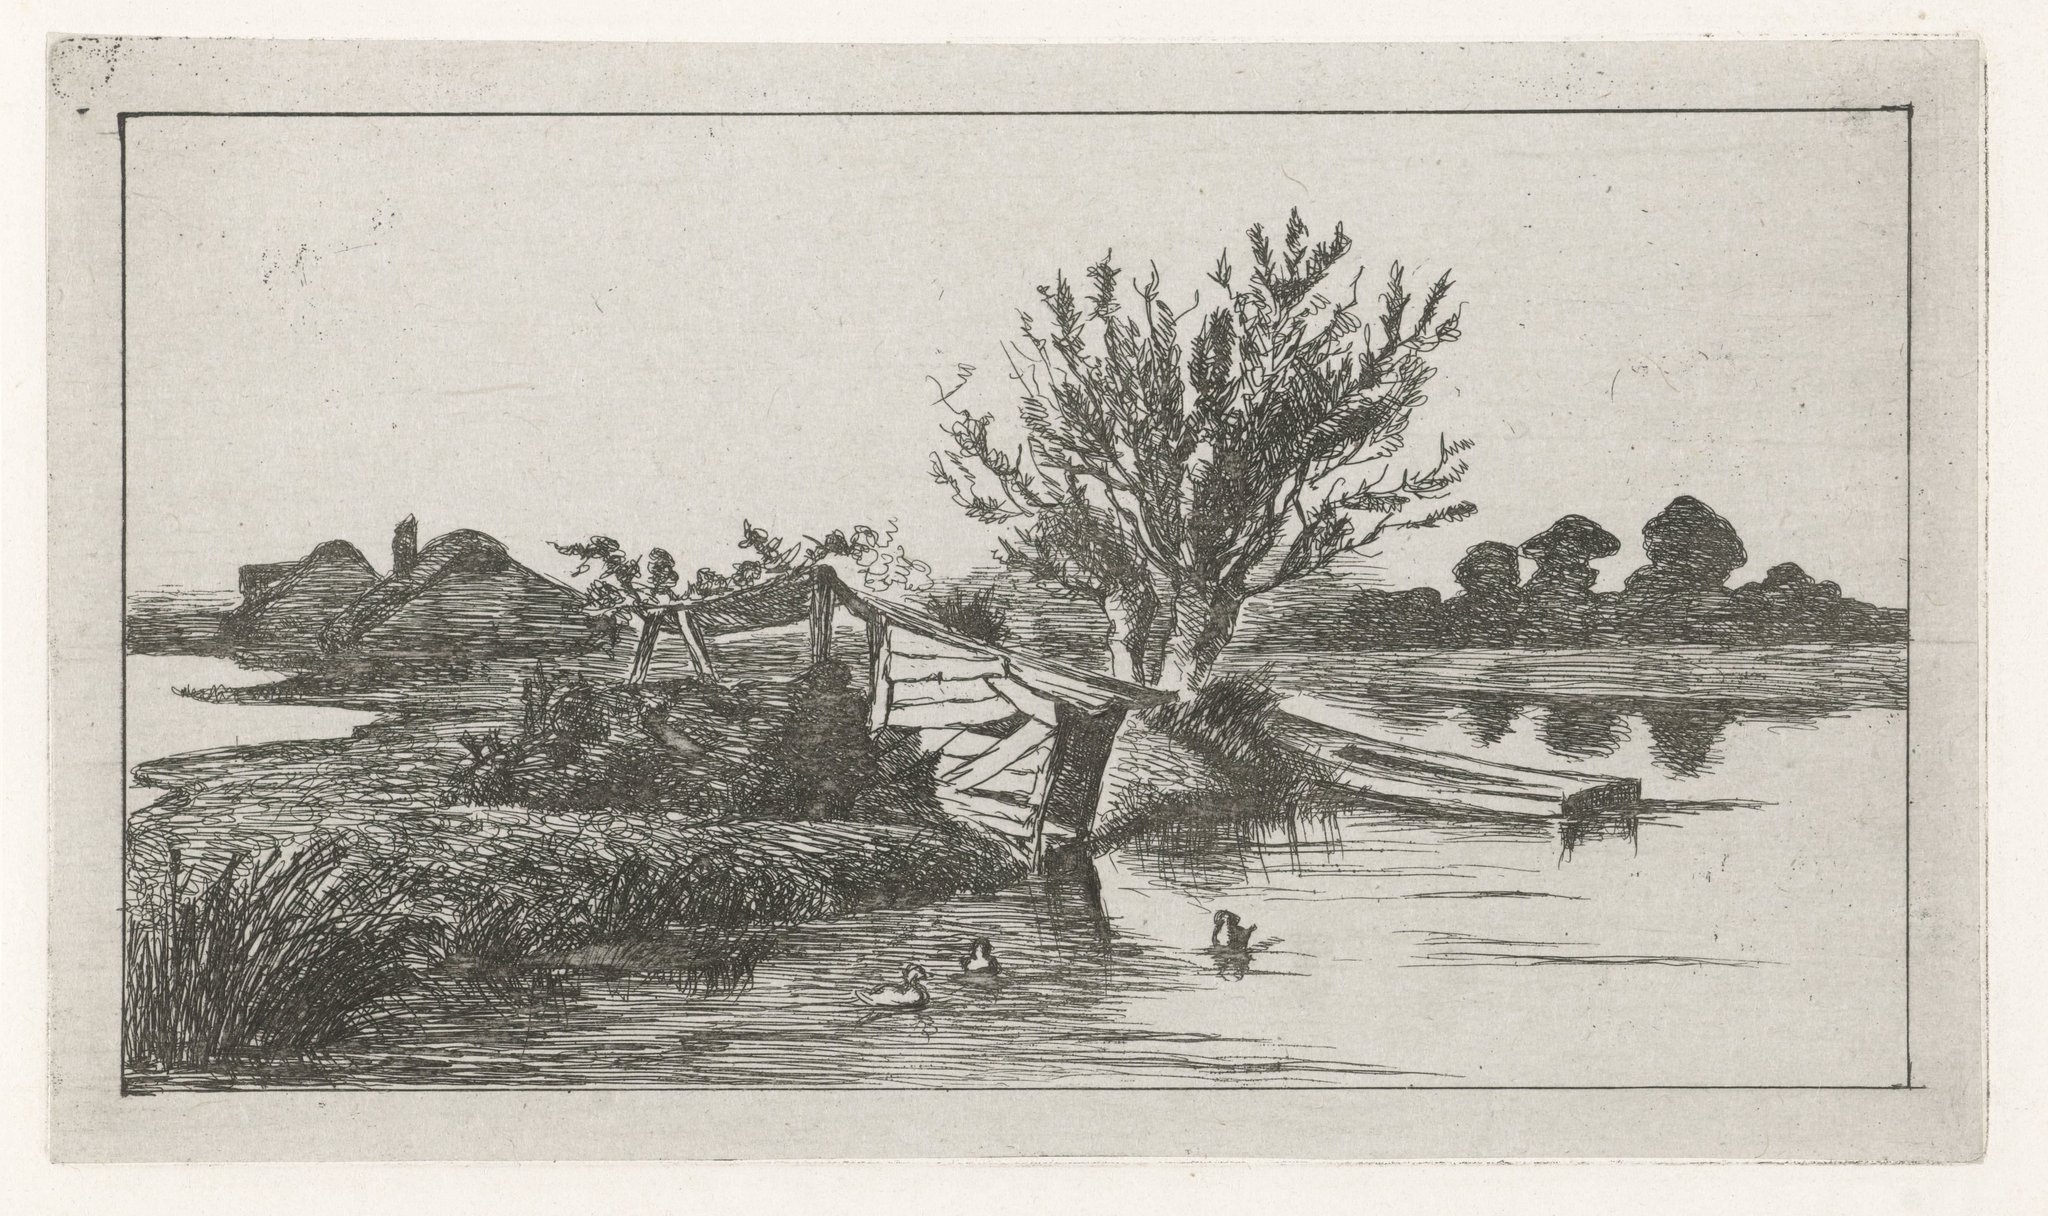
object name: print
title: Riviergezicht met eenden en een vervallen schuur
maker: johannes everhardus rijnboutt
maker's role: print maker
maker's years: 1839-1900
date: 1854-1889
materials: paper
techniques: etching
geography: netherlands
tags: river, farm or solitary house in landscape, water-birds: duck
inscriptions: collector's mark: Lugt 2228